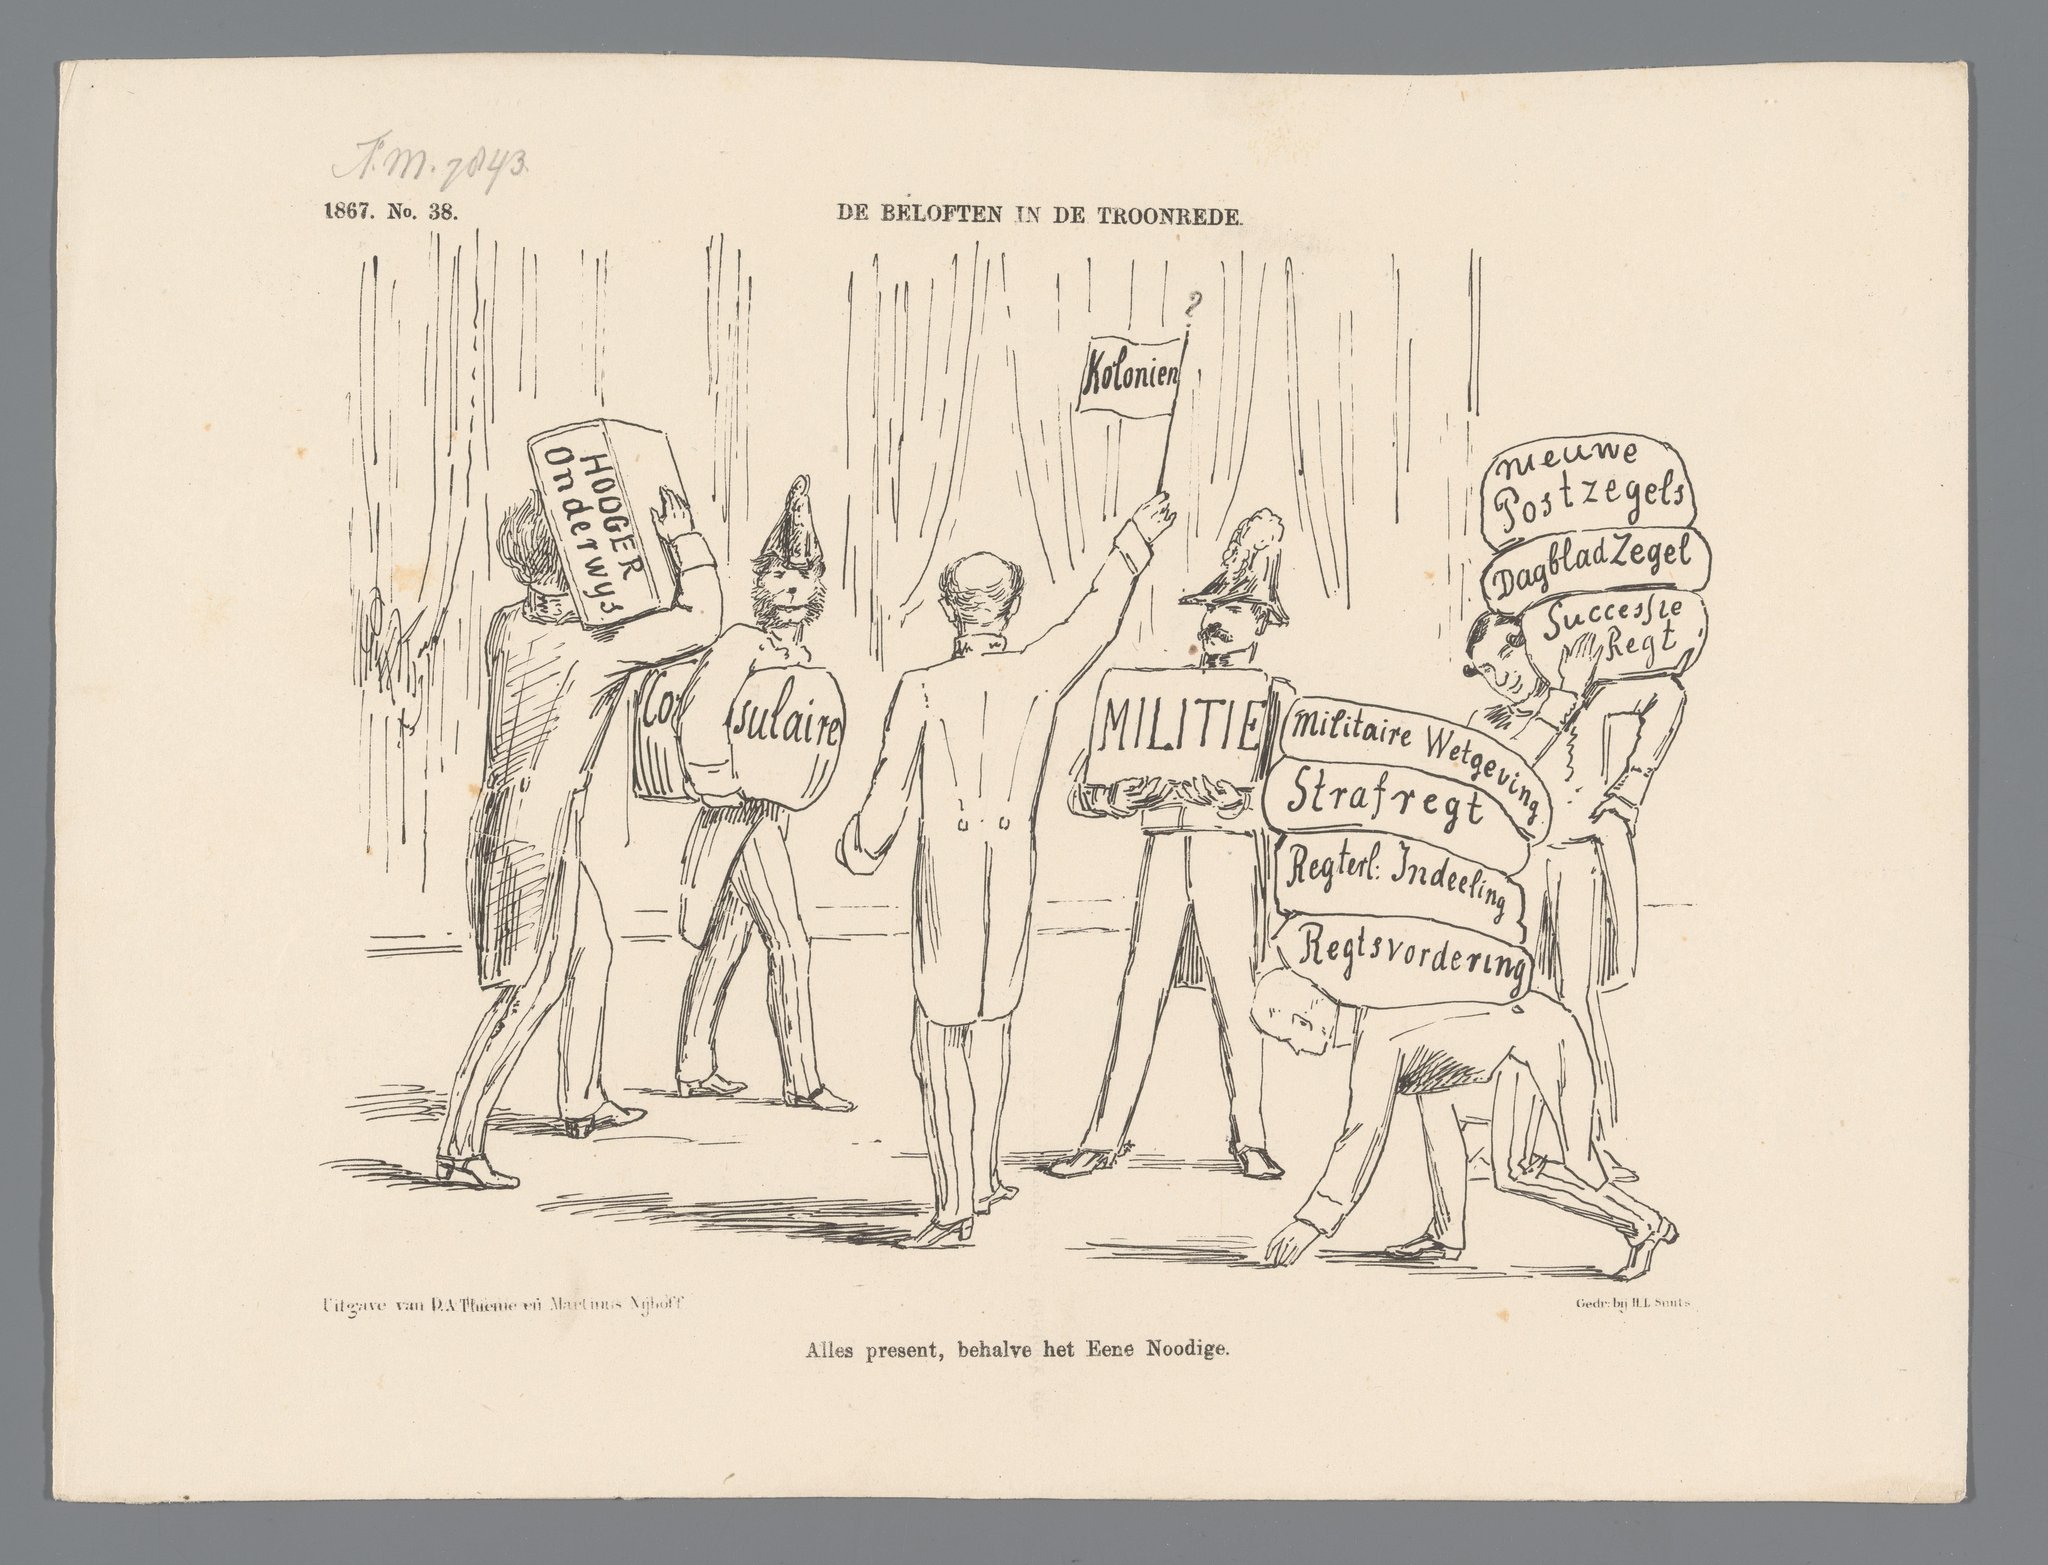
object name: print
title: Spotprent op het onaangeroerd laten van de koloniale kwestie in de troonrede, 1867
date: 1867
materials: paper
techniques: lithograph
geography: the hague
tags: ministerie van koloniën, minister van koloniën, johannes jerphaas hasselman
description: Spotprent op het onaangeroerd laten van de koloniale kwestie in de troonrede bij de opening van de Staten-Generaal. Verschillende ministers met hun pakken, Hasselman zwaait met een vlaggetje. Plaat verschenen bij het weekblad De Nederlandsche Spectator, nr. 38, 21 september 1867.